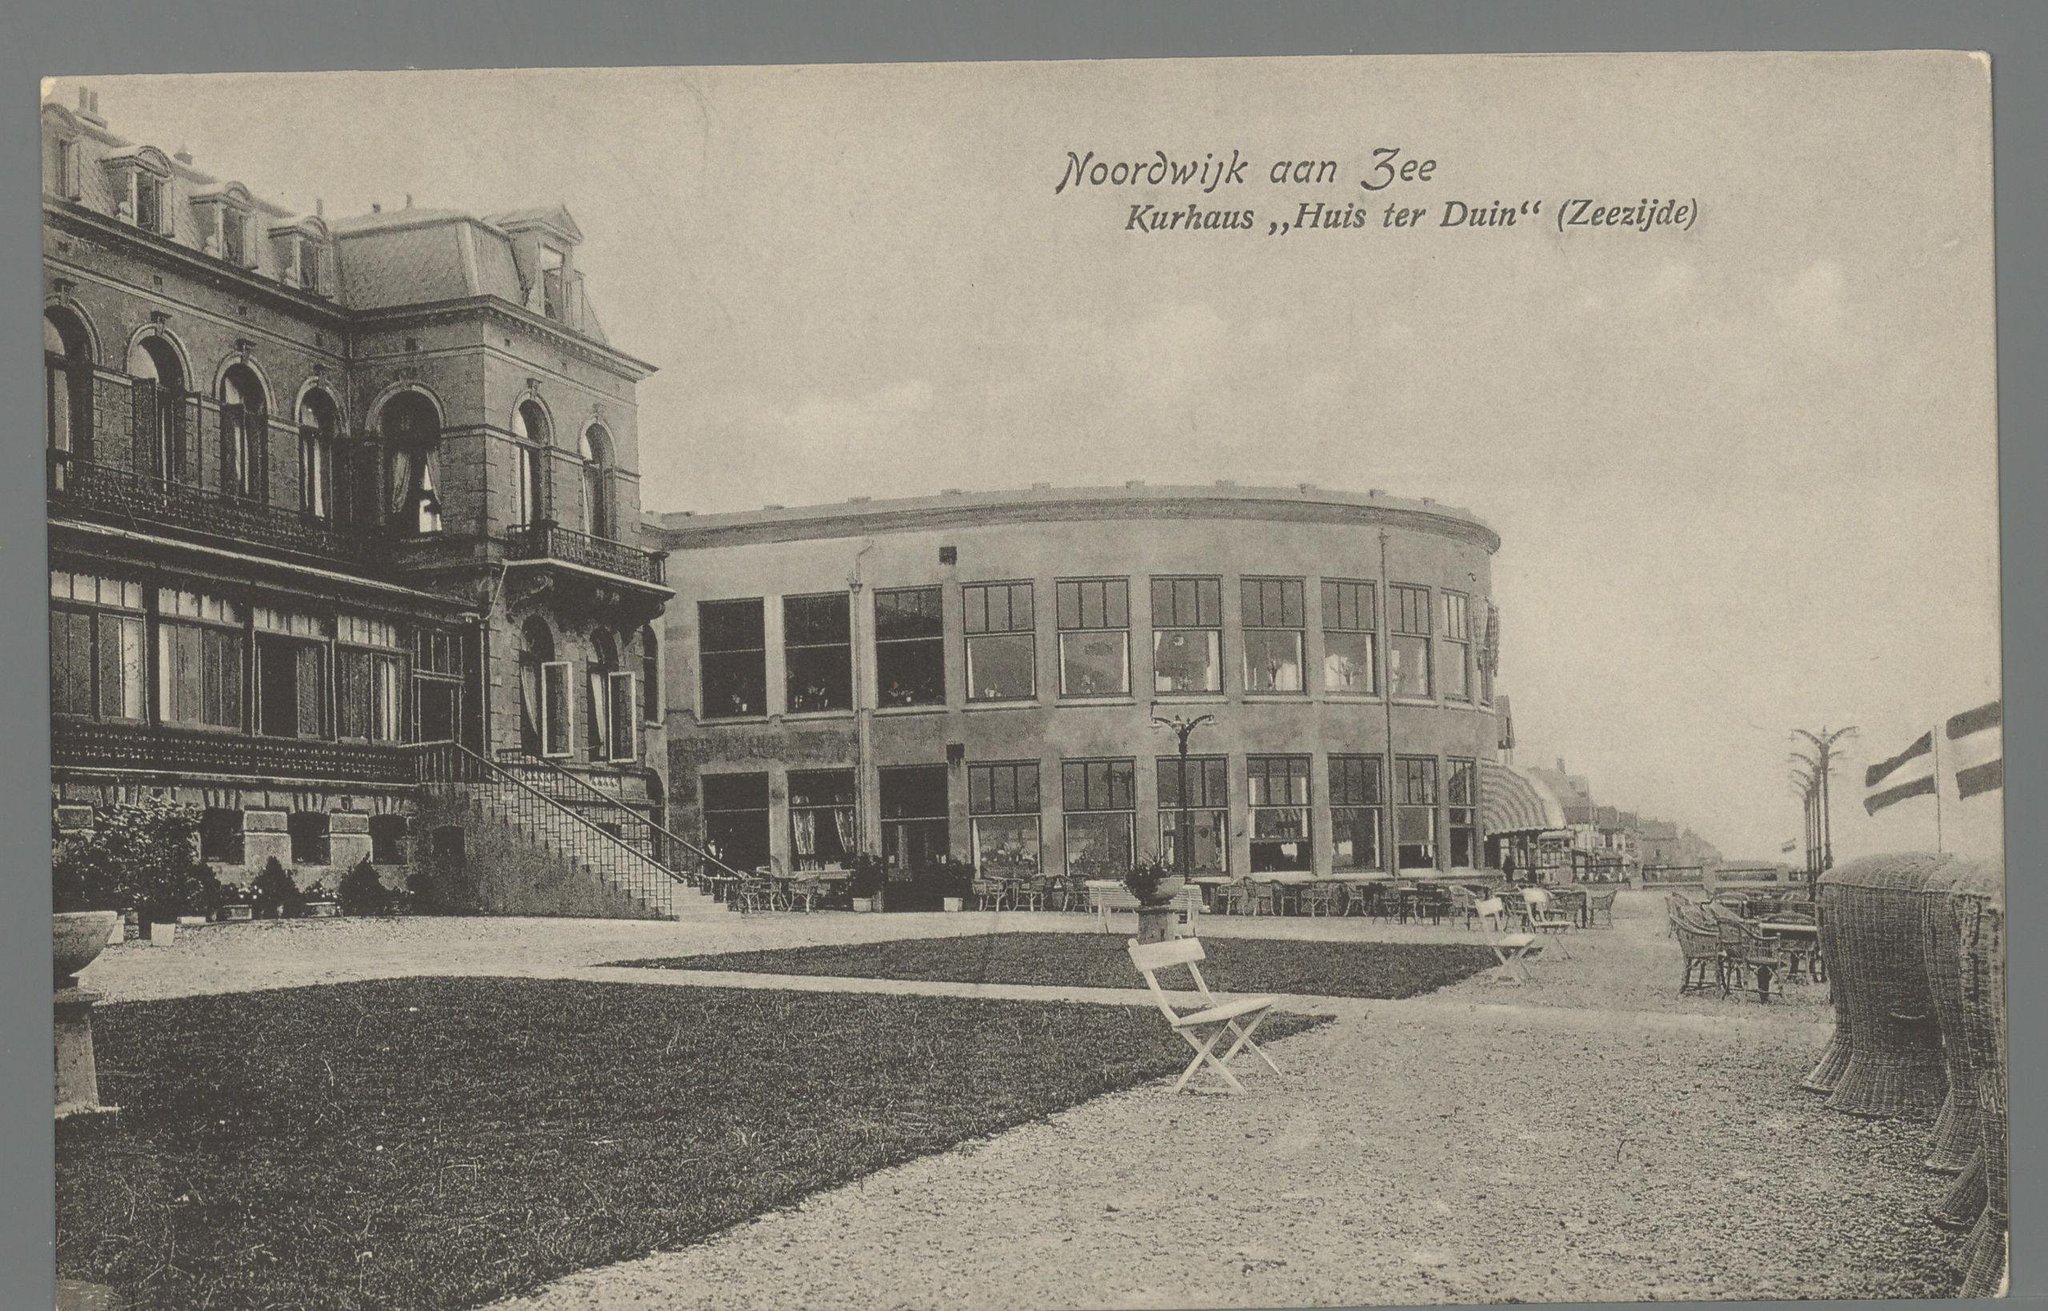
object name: ansichtkaart, prentbriefkaart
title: Noordwijk aan Zee. Kurhaus "Huis ter Duin" (zeezijde)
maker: Anonymous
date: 1912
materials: cardboard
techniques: photograph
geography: noordwijk aan zee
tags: hotel, hostelry, inn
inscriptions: date